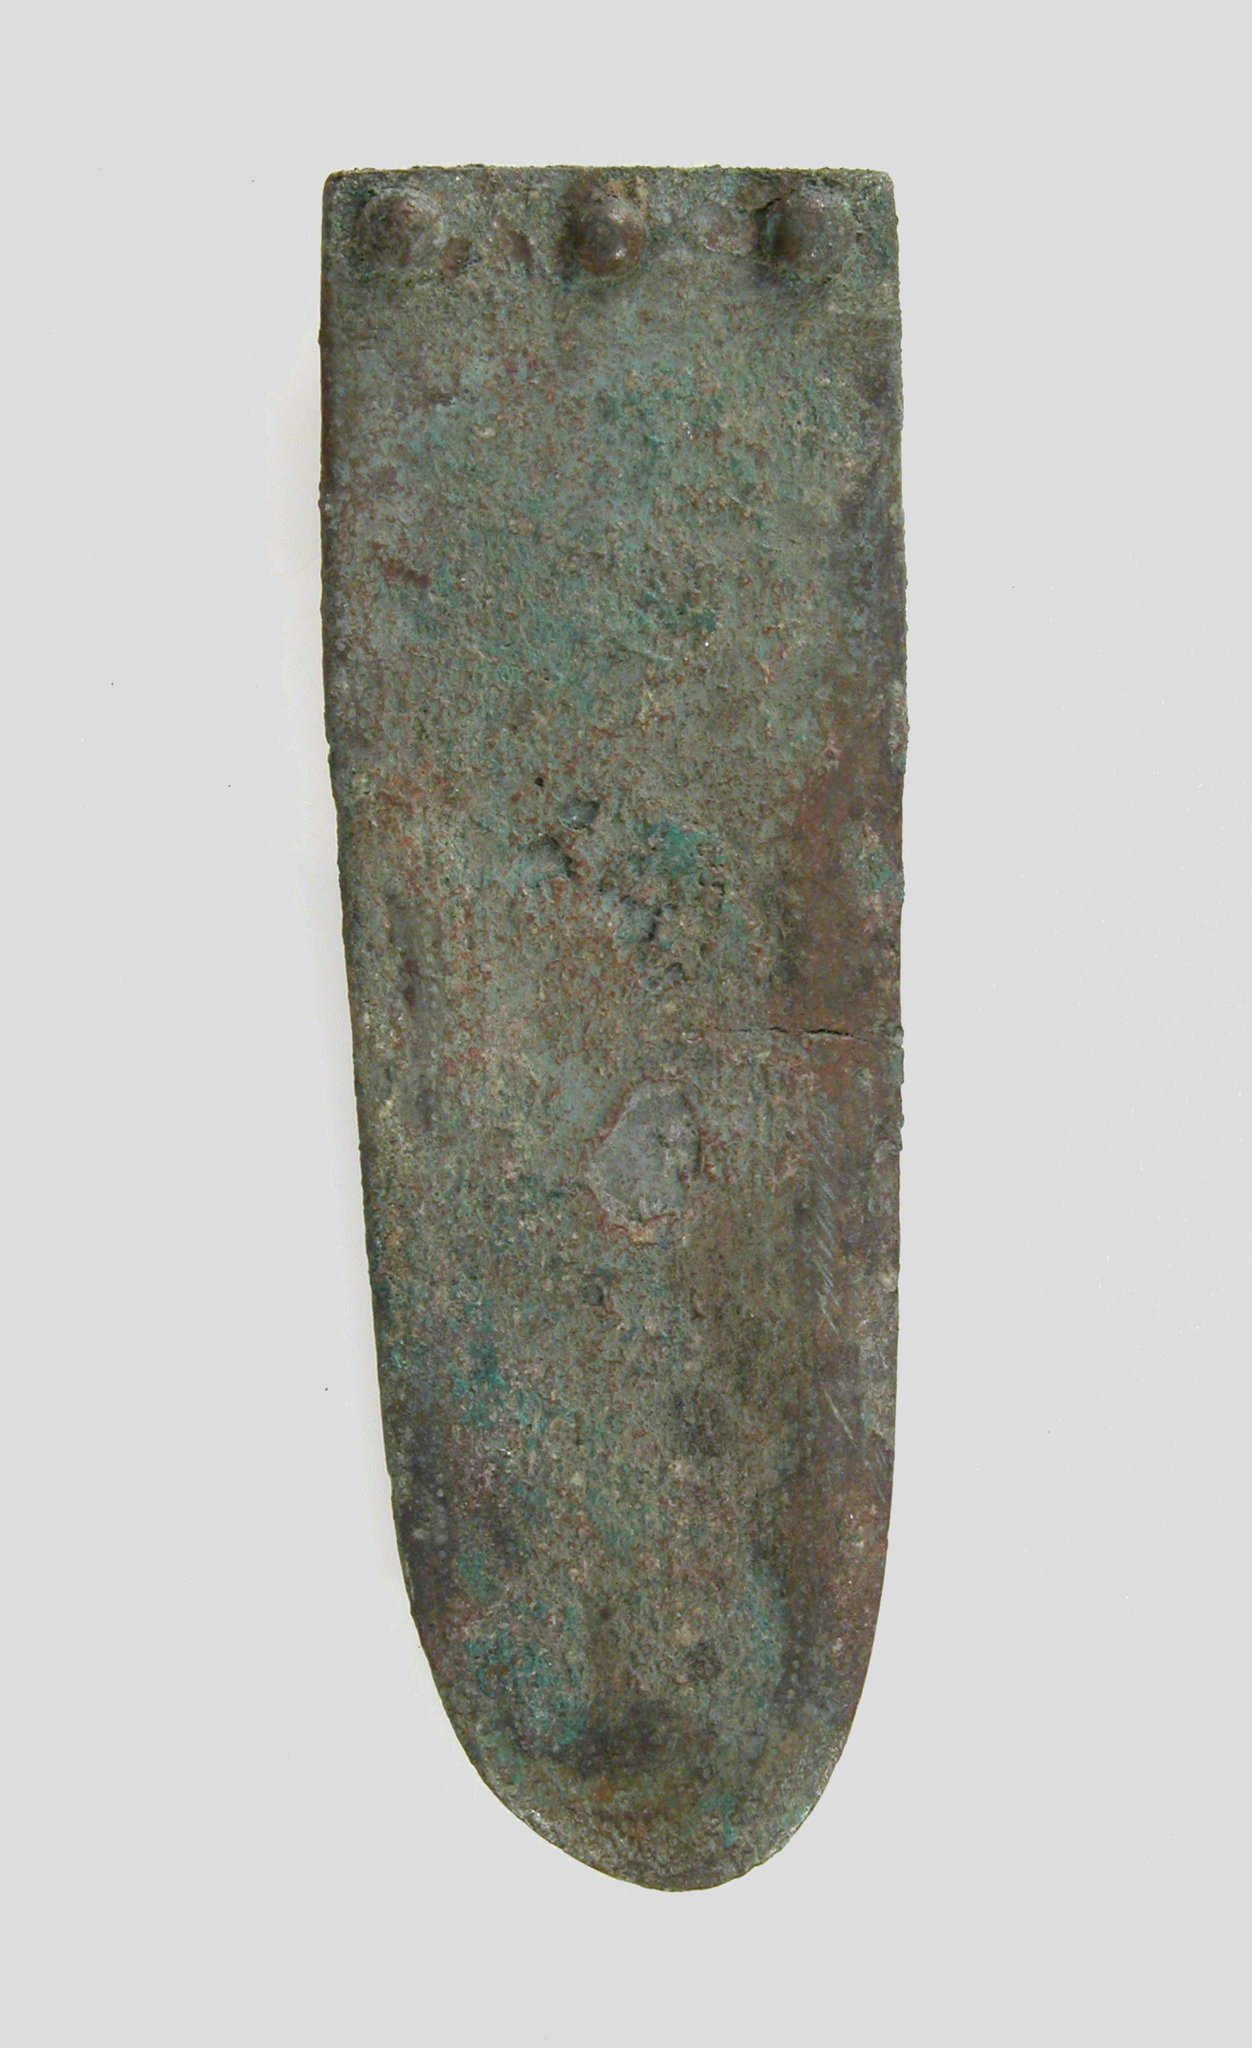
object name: ferret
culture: roman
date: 501-700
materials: copper alloy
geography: germany